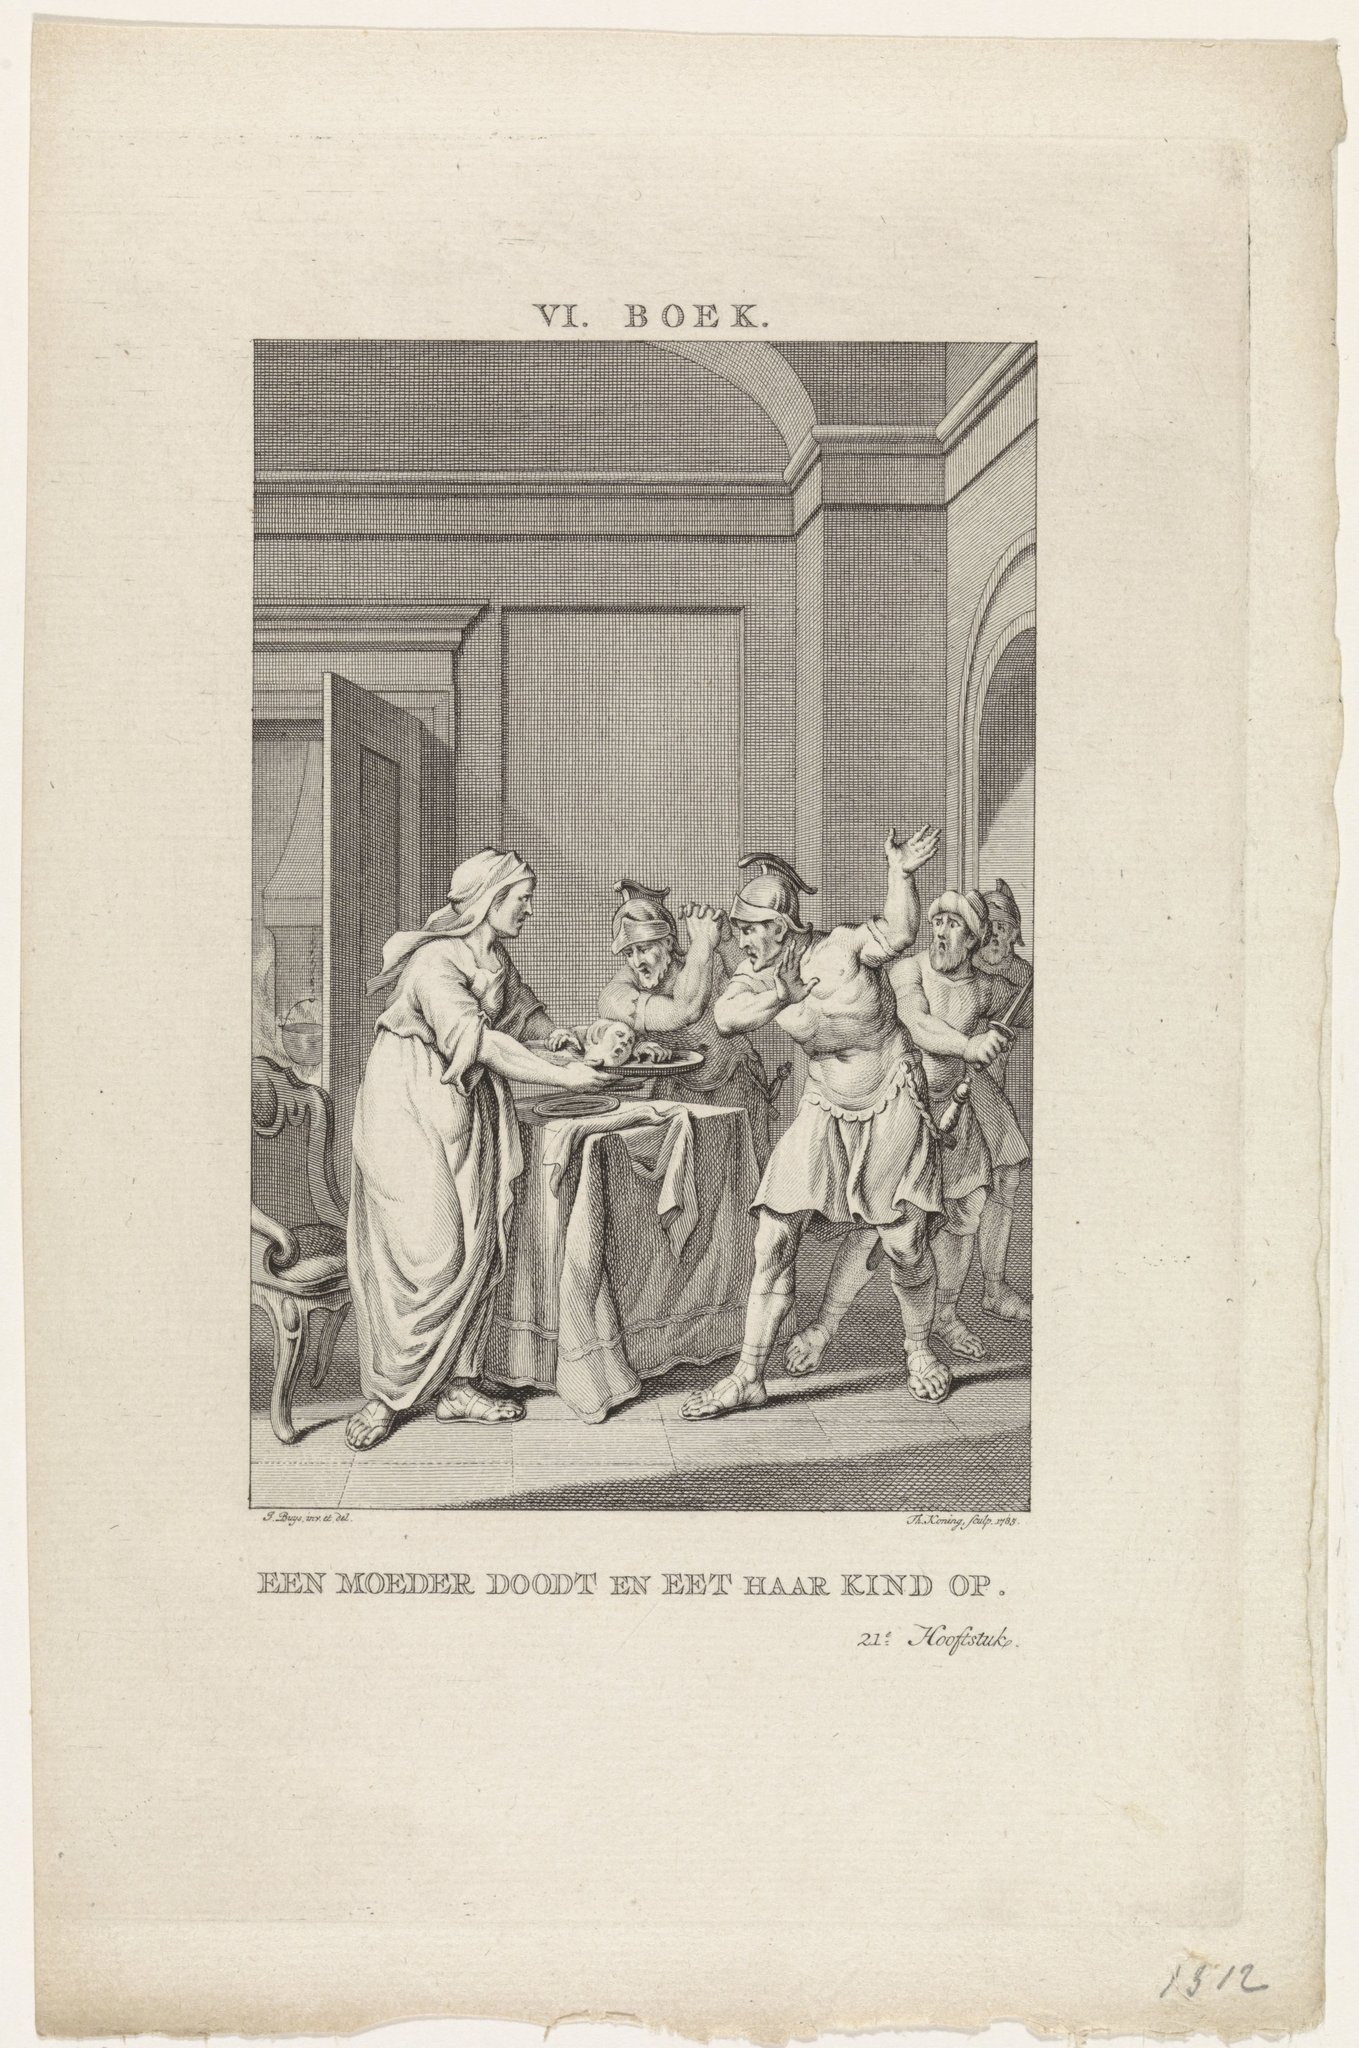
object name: print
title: Een moeder doodt en eet haar kind op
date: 1785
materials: paper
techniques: engraving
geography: amsterdam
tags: mother and baby or young child, the massacre of the innocents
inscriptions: collector's mark: Lugt 2228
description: In een vertrek biedt een vrouw vier soldaten een bord, met daarop het hoofd en de handen van haar kind, als maaltijd aan. Een gedeelte van het kind heeft ze reeds zelf gegeten. Deze prent is een illustratie bij het eenentwintigste hoofdstuk van het zesde boek van 'Alle de werken van Flavius Josephus'.